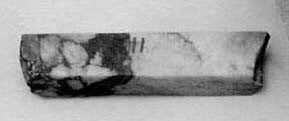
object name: fragment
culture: burmese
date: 1902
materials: jade